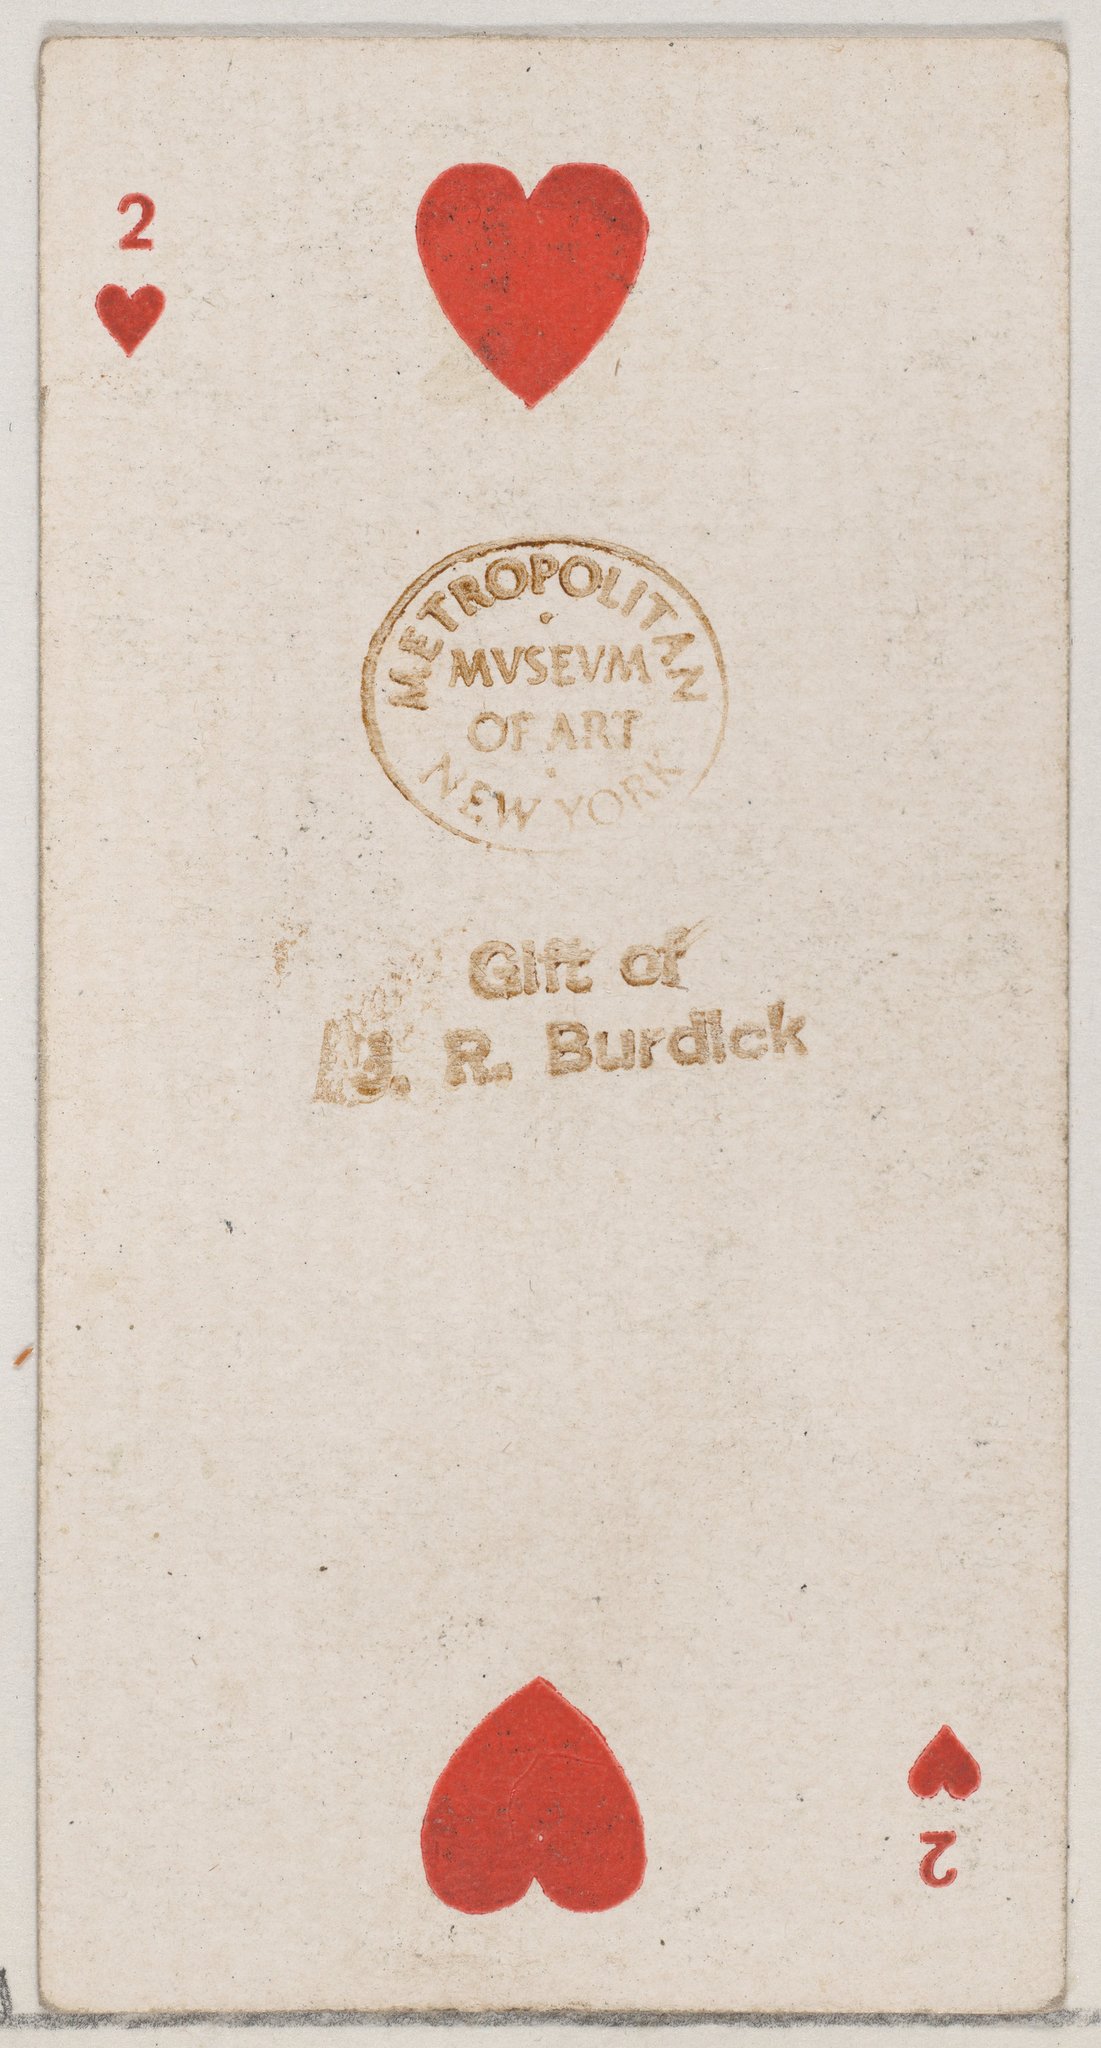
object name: print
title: Two Hearts (red), from the Playing Cards series (N84) for Duke brand cigarettes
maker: w. duke, sons & co.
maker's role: publisher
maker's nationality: american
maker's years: 1870-1920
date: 1888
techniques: color lithograph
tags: playing cards